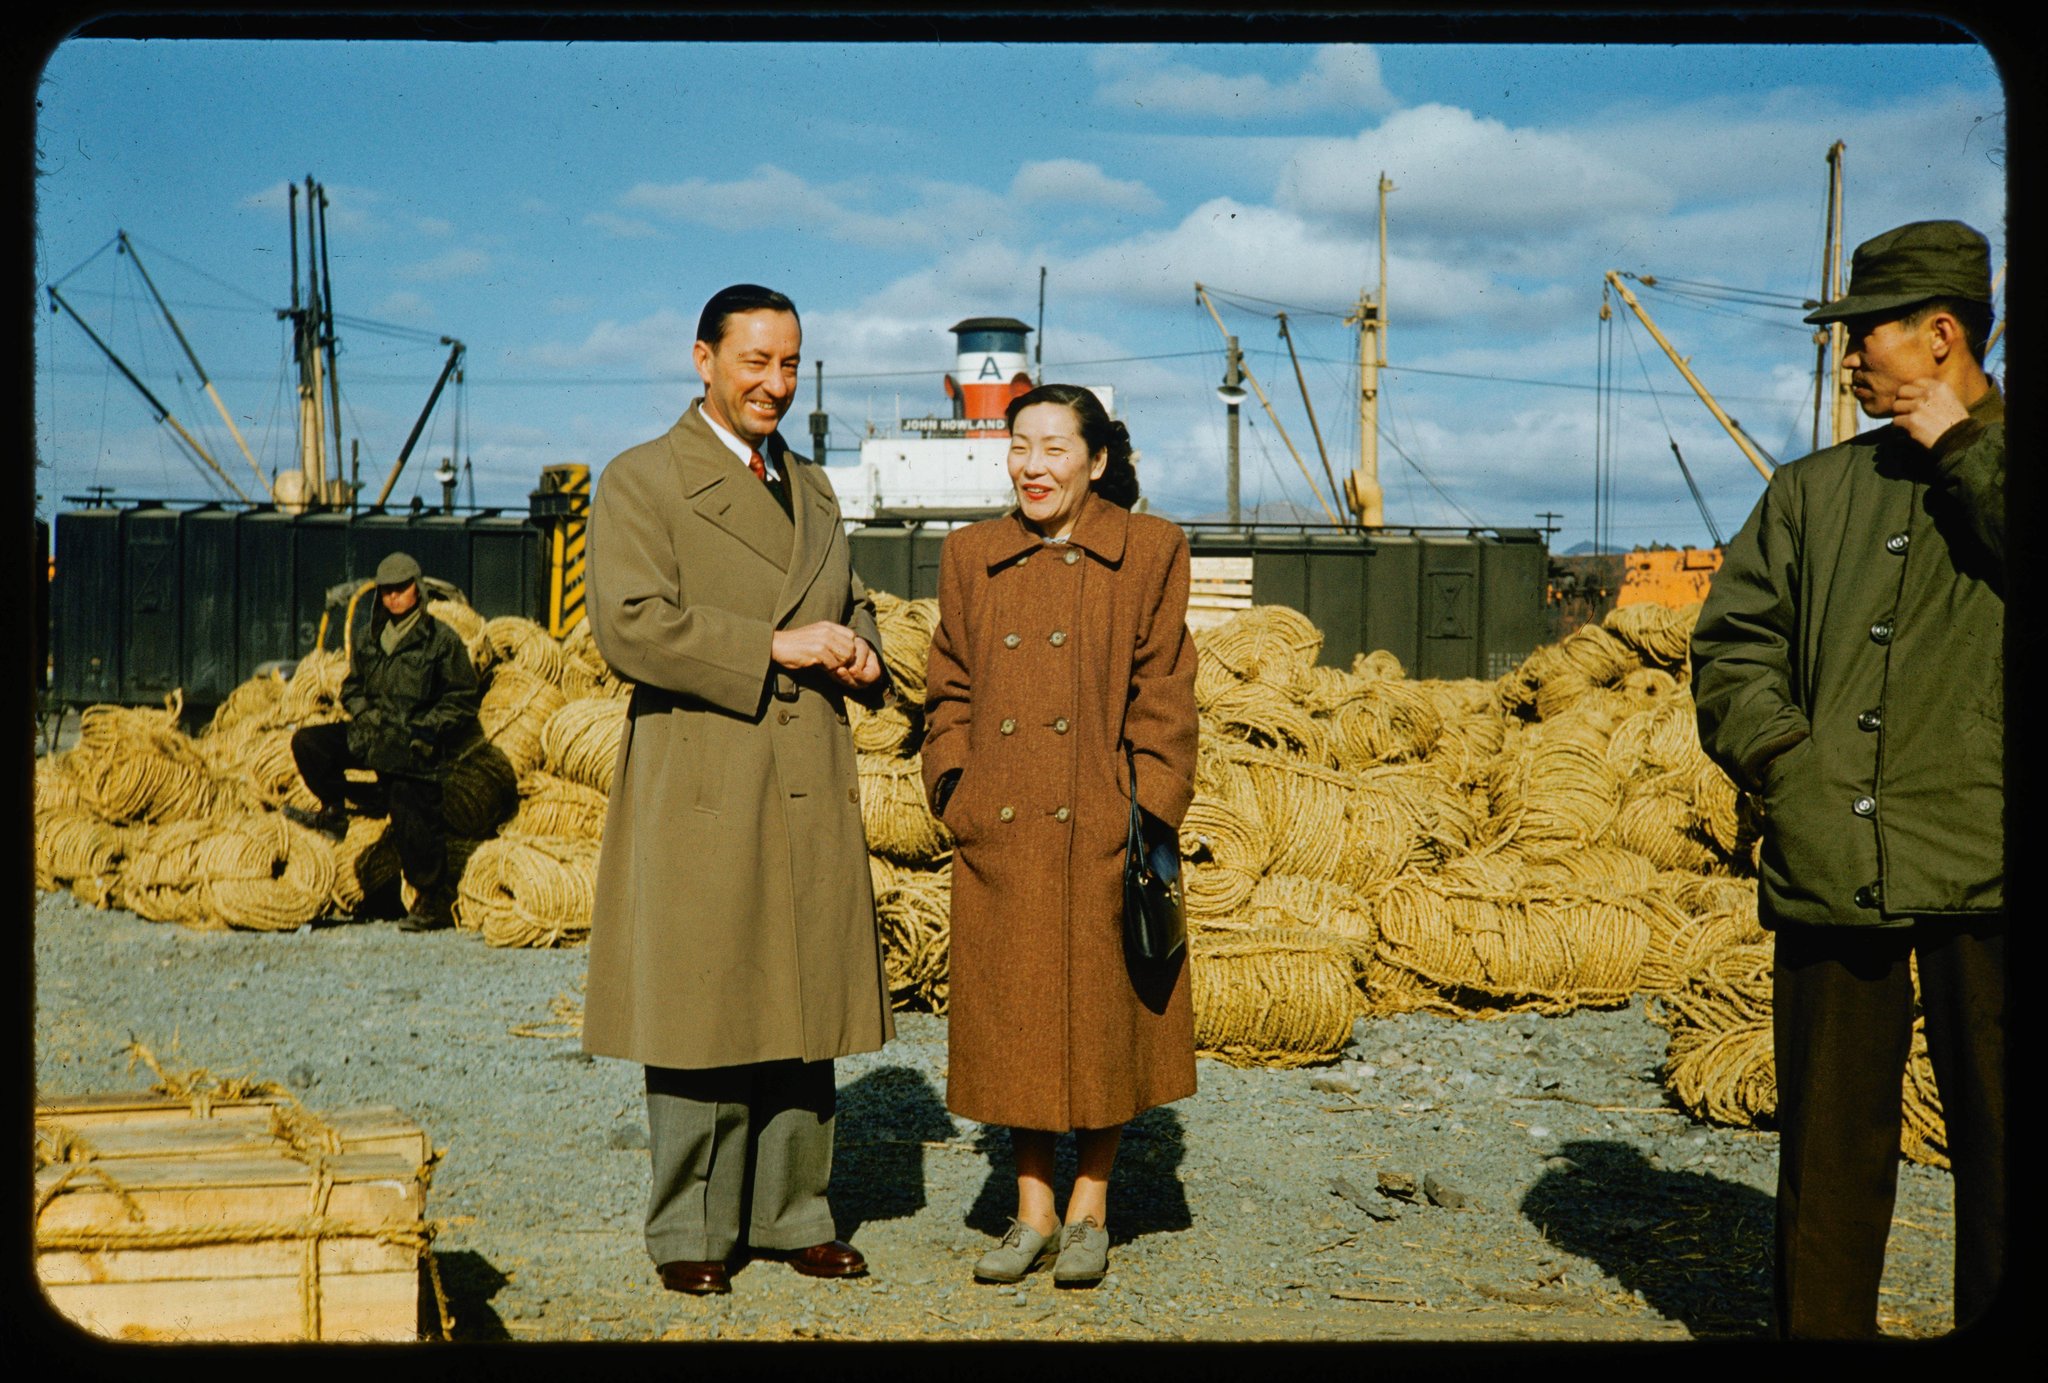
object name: color slide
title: Een schip met graan van de UNKRA, Busan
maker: david ketel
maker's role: diplomaat, sinoloog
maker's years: 1913-2008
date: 1952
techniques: slide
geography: busan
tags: united nations